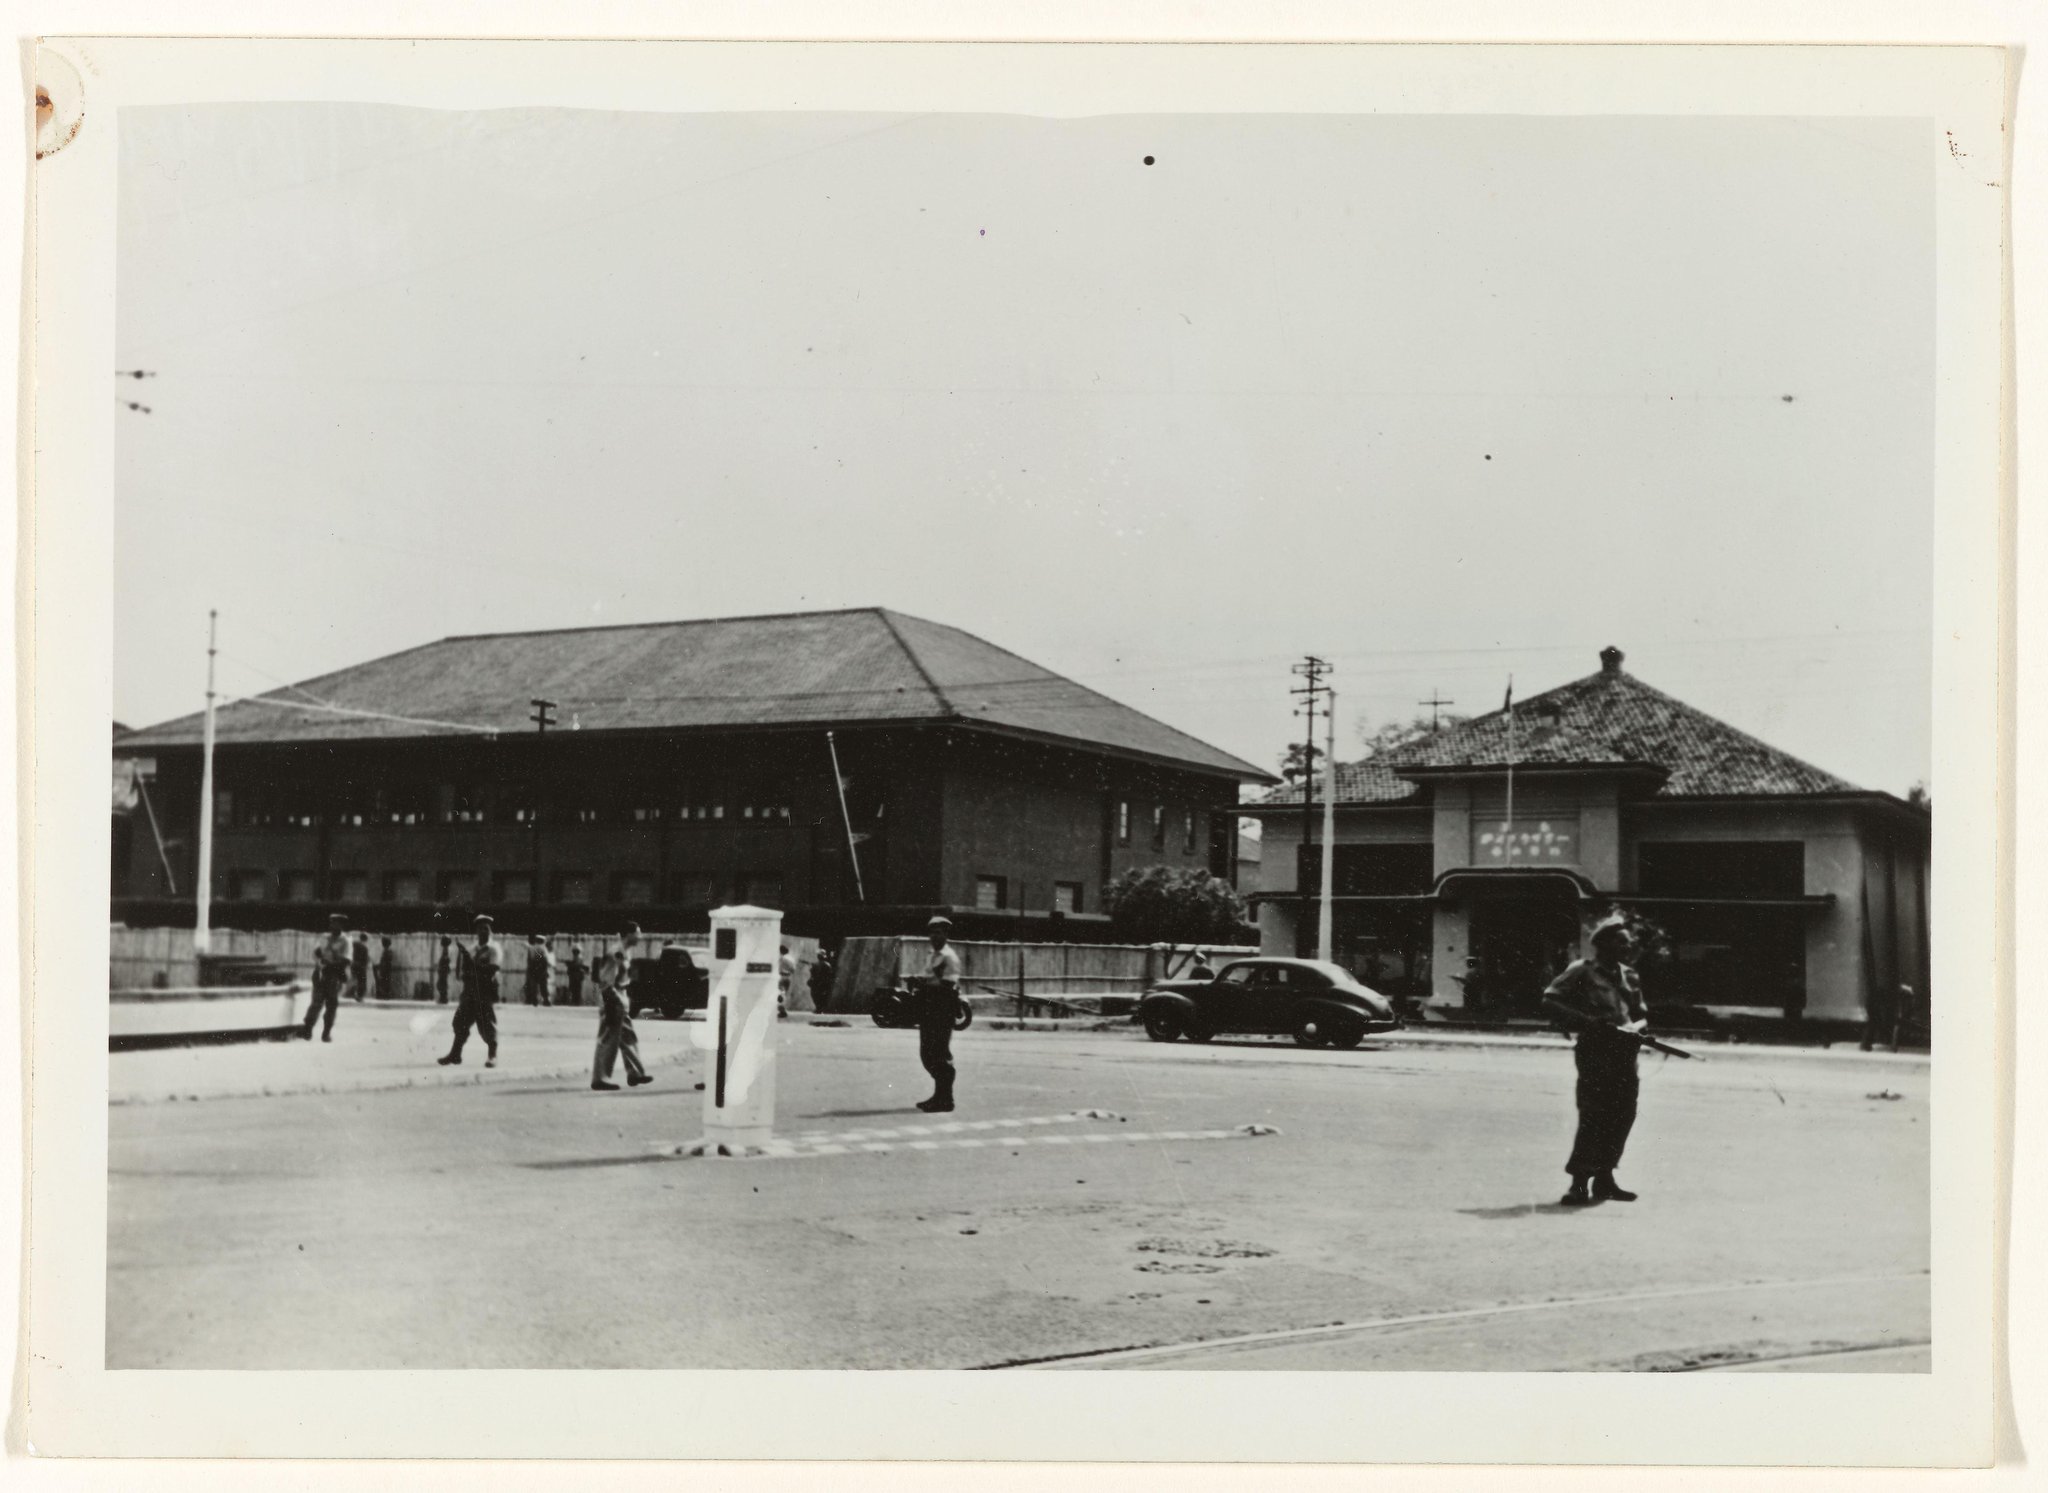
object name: photograph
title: Bewaking door Nederlands Indische Marine van regeringsgebouwen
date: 1945-1946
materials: photographic support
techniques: photography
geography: indonesia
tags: batavia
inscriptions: inscription, stamp: ‘COPYRIGHT / 'ANEFO' / ALGEMEEN NEDERLANDSCH FOTOBUREAU’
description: Bewaking door Nederlands Indische Marine van regeringsgebouwen tegen aanvallen van "extremistische elementen" te Batavia.